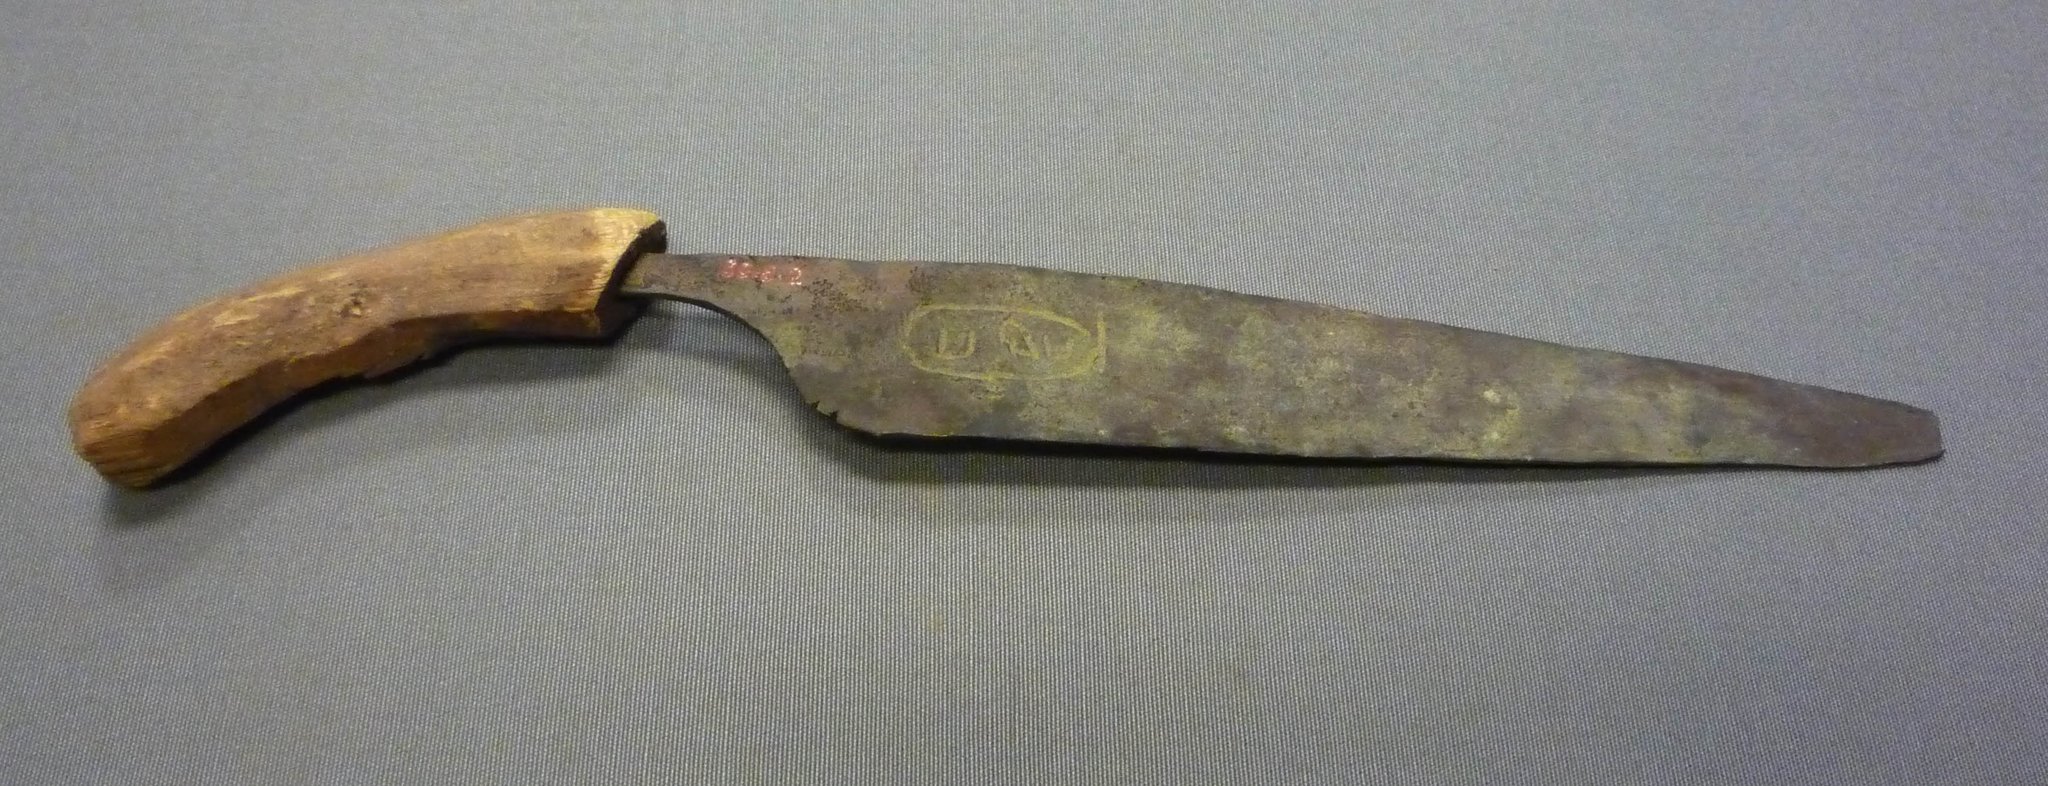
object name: model saw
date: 1479-1458 BCE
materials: bronze, copper alloy, wood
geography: egypt